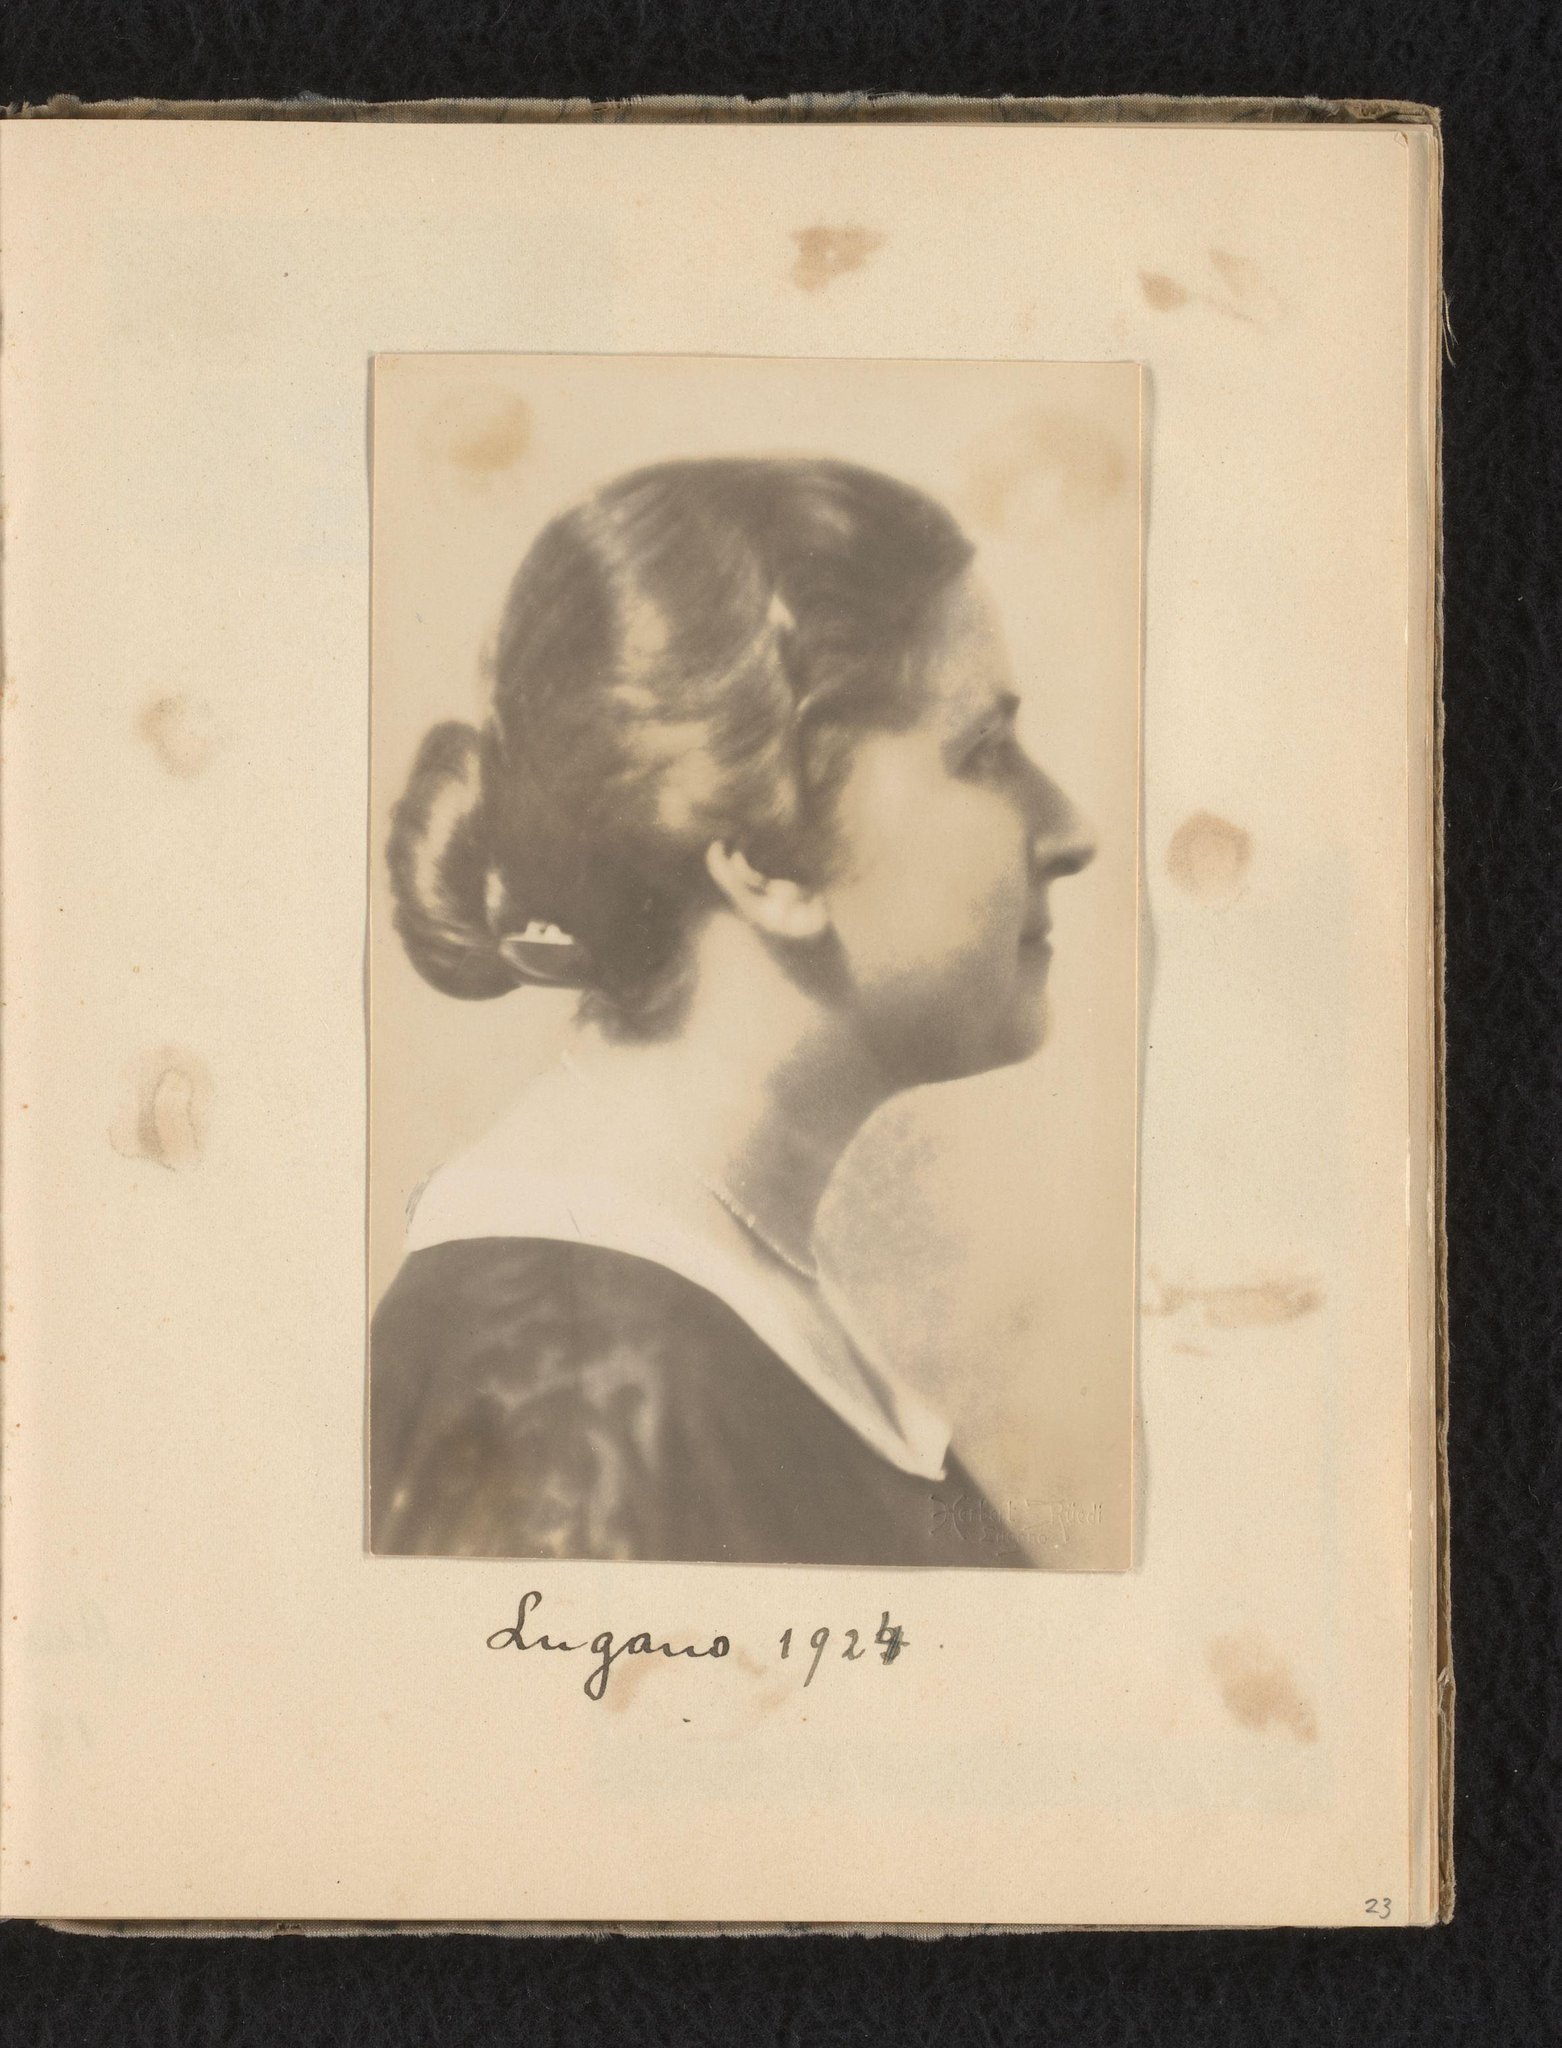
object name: photograph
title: Portret en profil van Else Wachenheimer-Moos, 1924, Lugano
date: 1924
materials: paper, photographic support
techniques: gelatin silver print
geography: lugano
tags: else wachenheimer-moos, the family travelling, on holiday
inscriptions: inscription: ‘Lugano 1924’, name: ‘Herbert Rüedi Lugano’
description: Blad bevat een foto van Else Wachenheimer-Moos. Onderdeel van het fotoalbum van de reizen die Eugen en Else Wachenheimer jaarlijks maakten rondom de viering van hun huwelijksdag en verloving.